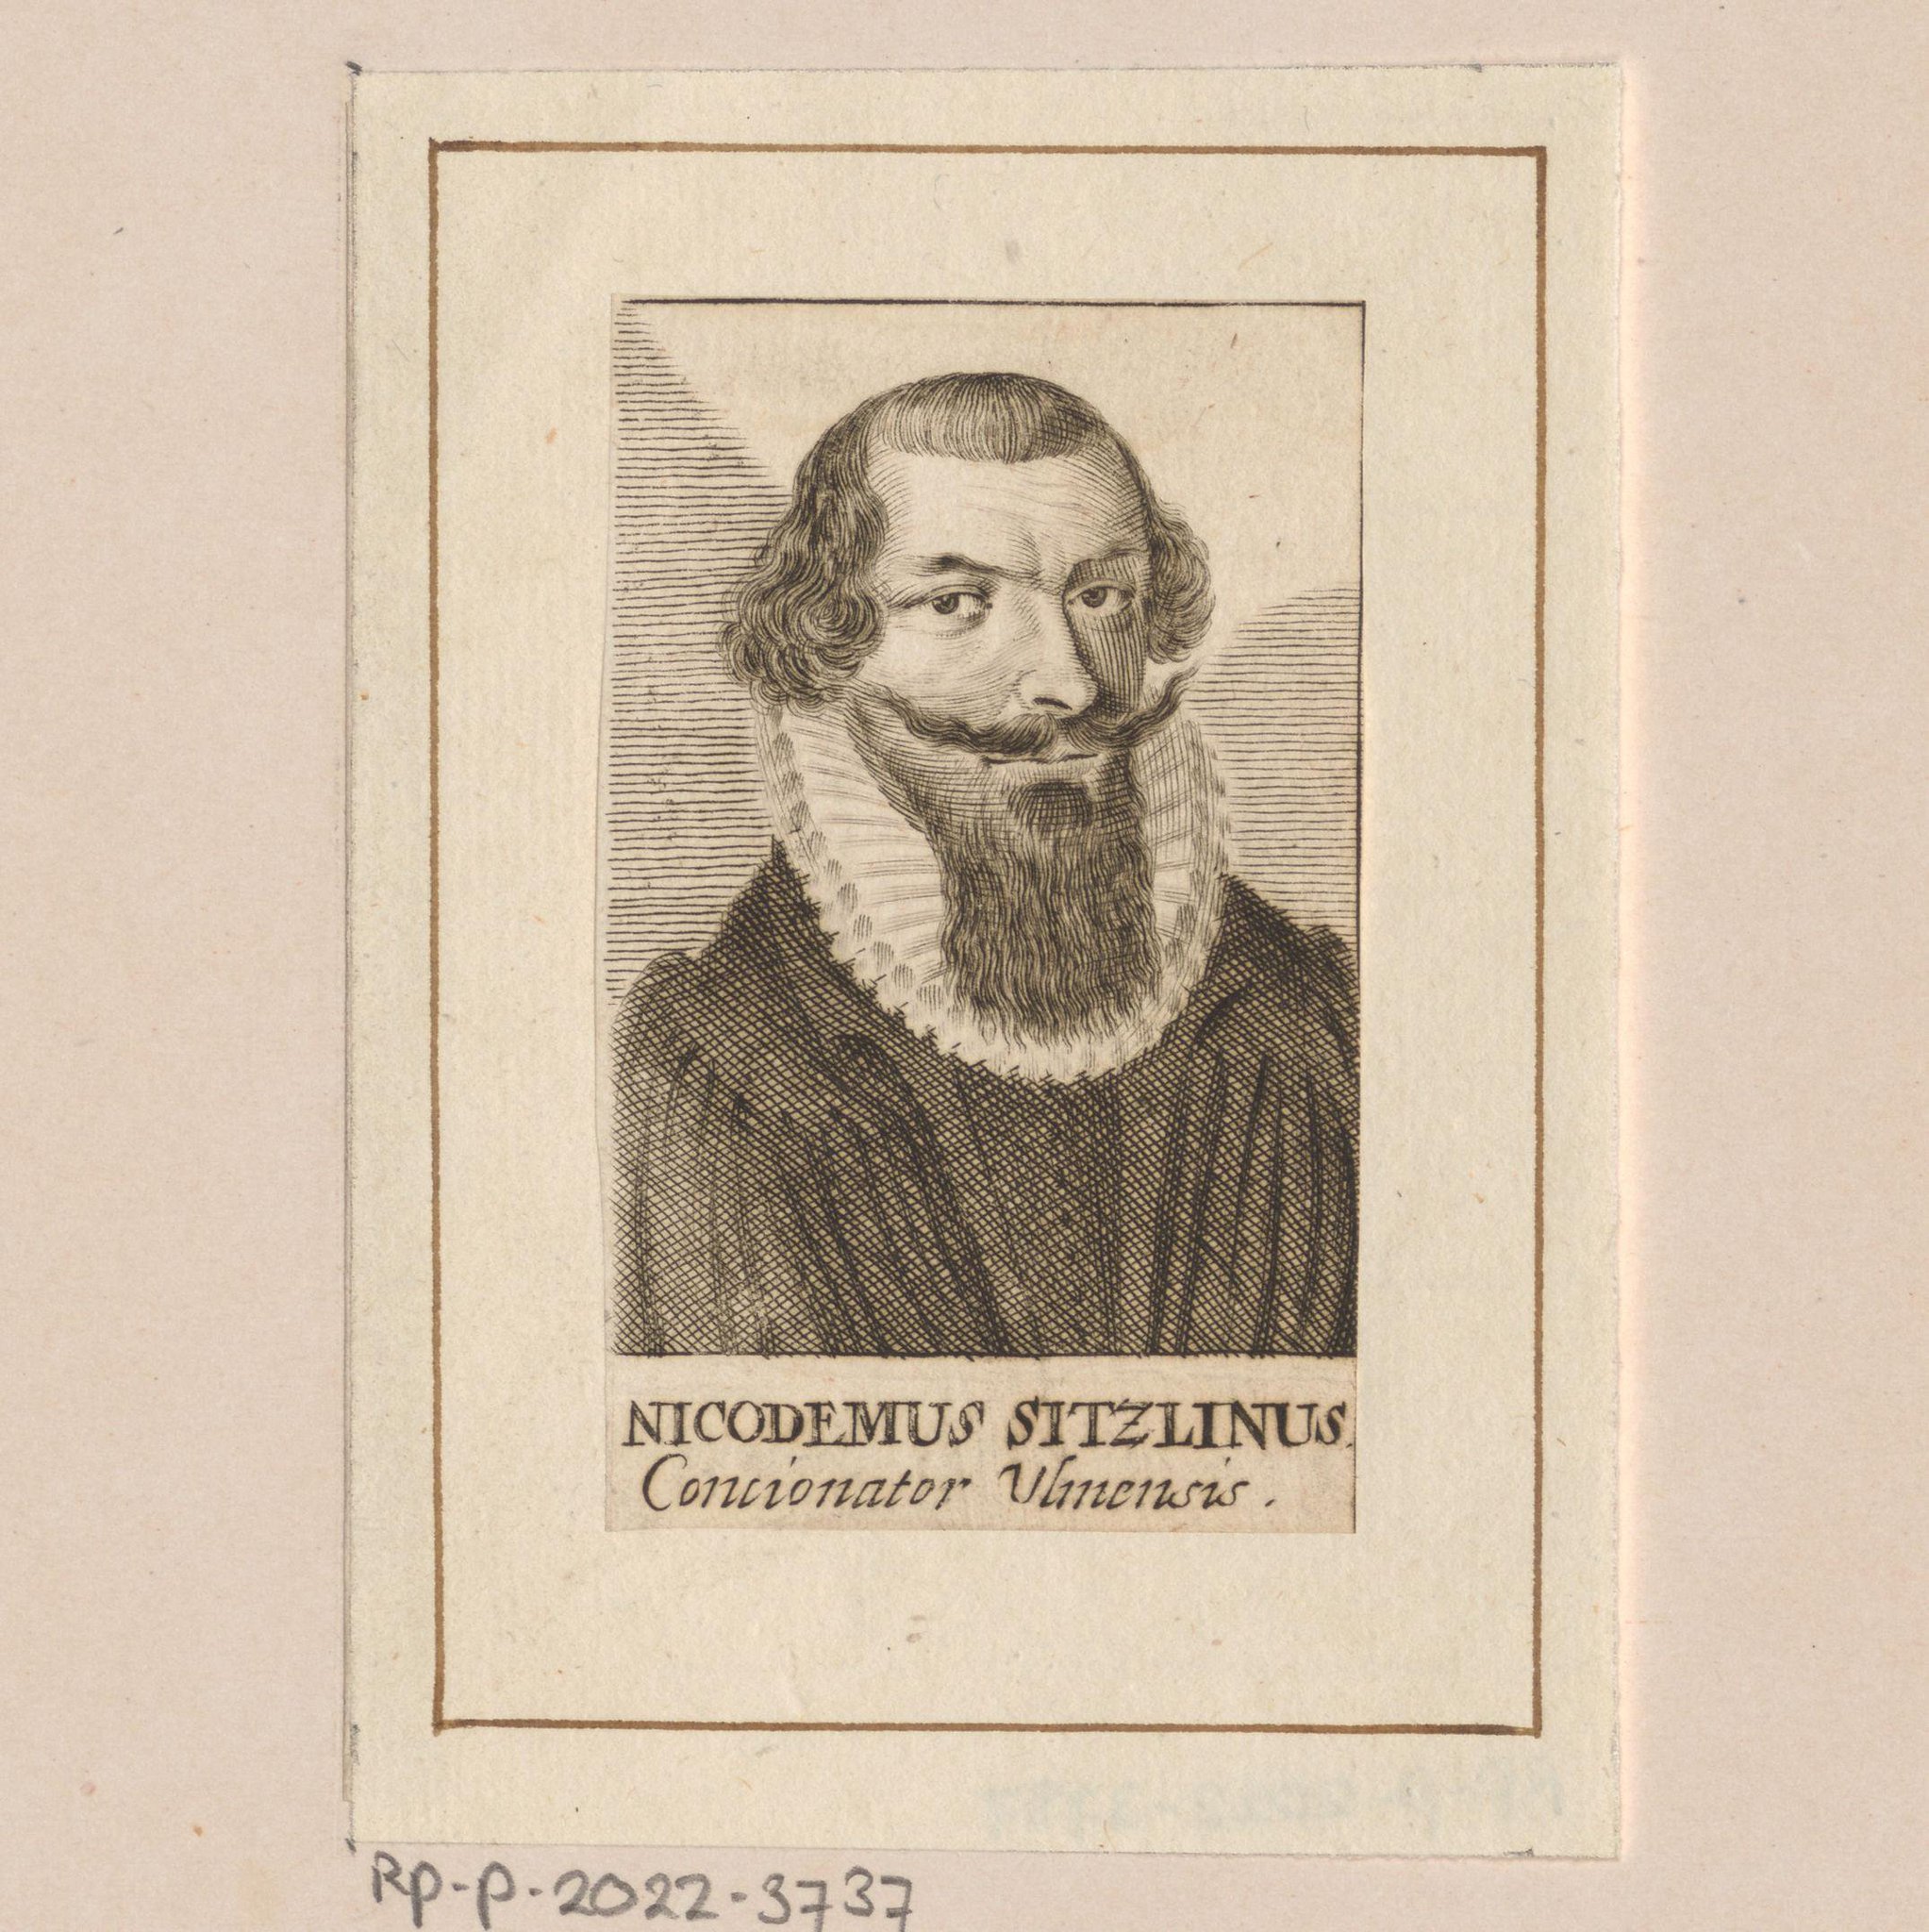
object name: print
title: Portret van Nicodemus Sitzlin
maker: Anonymous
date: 1688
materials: ink, paper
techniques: engraving, pen, snipping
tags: theologian, historical persons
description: Prent uit: Freher, Paul. Theatrum virorum eruditione clarorum. Neurenberg: Johann Hoffmann, 1688.